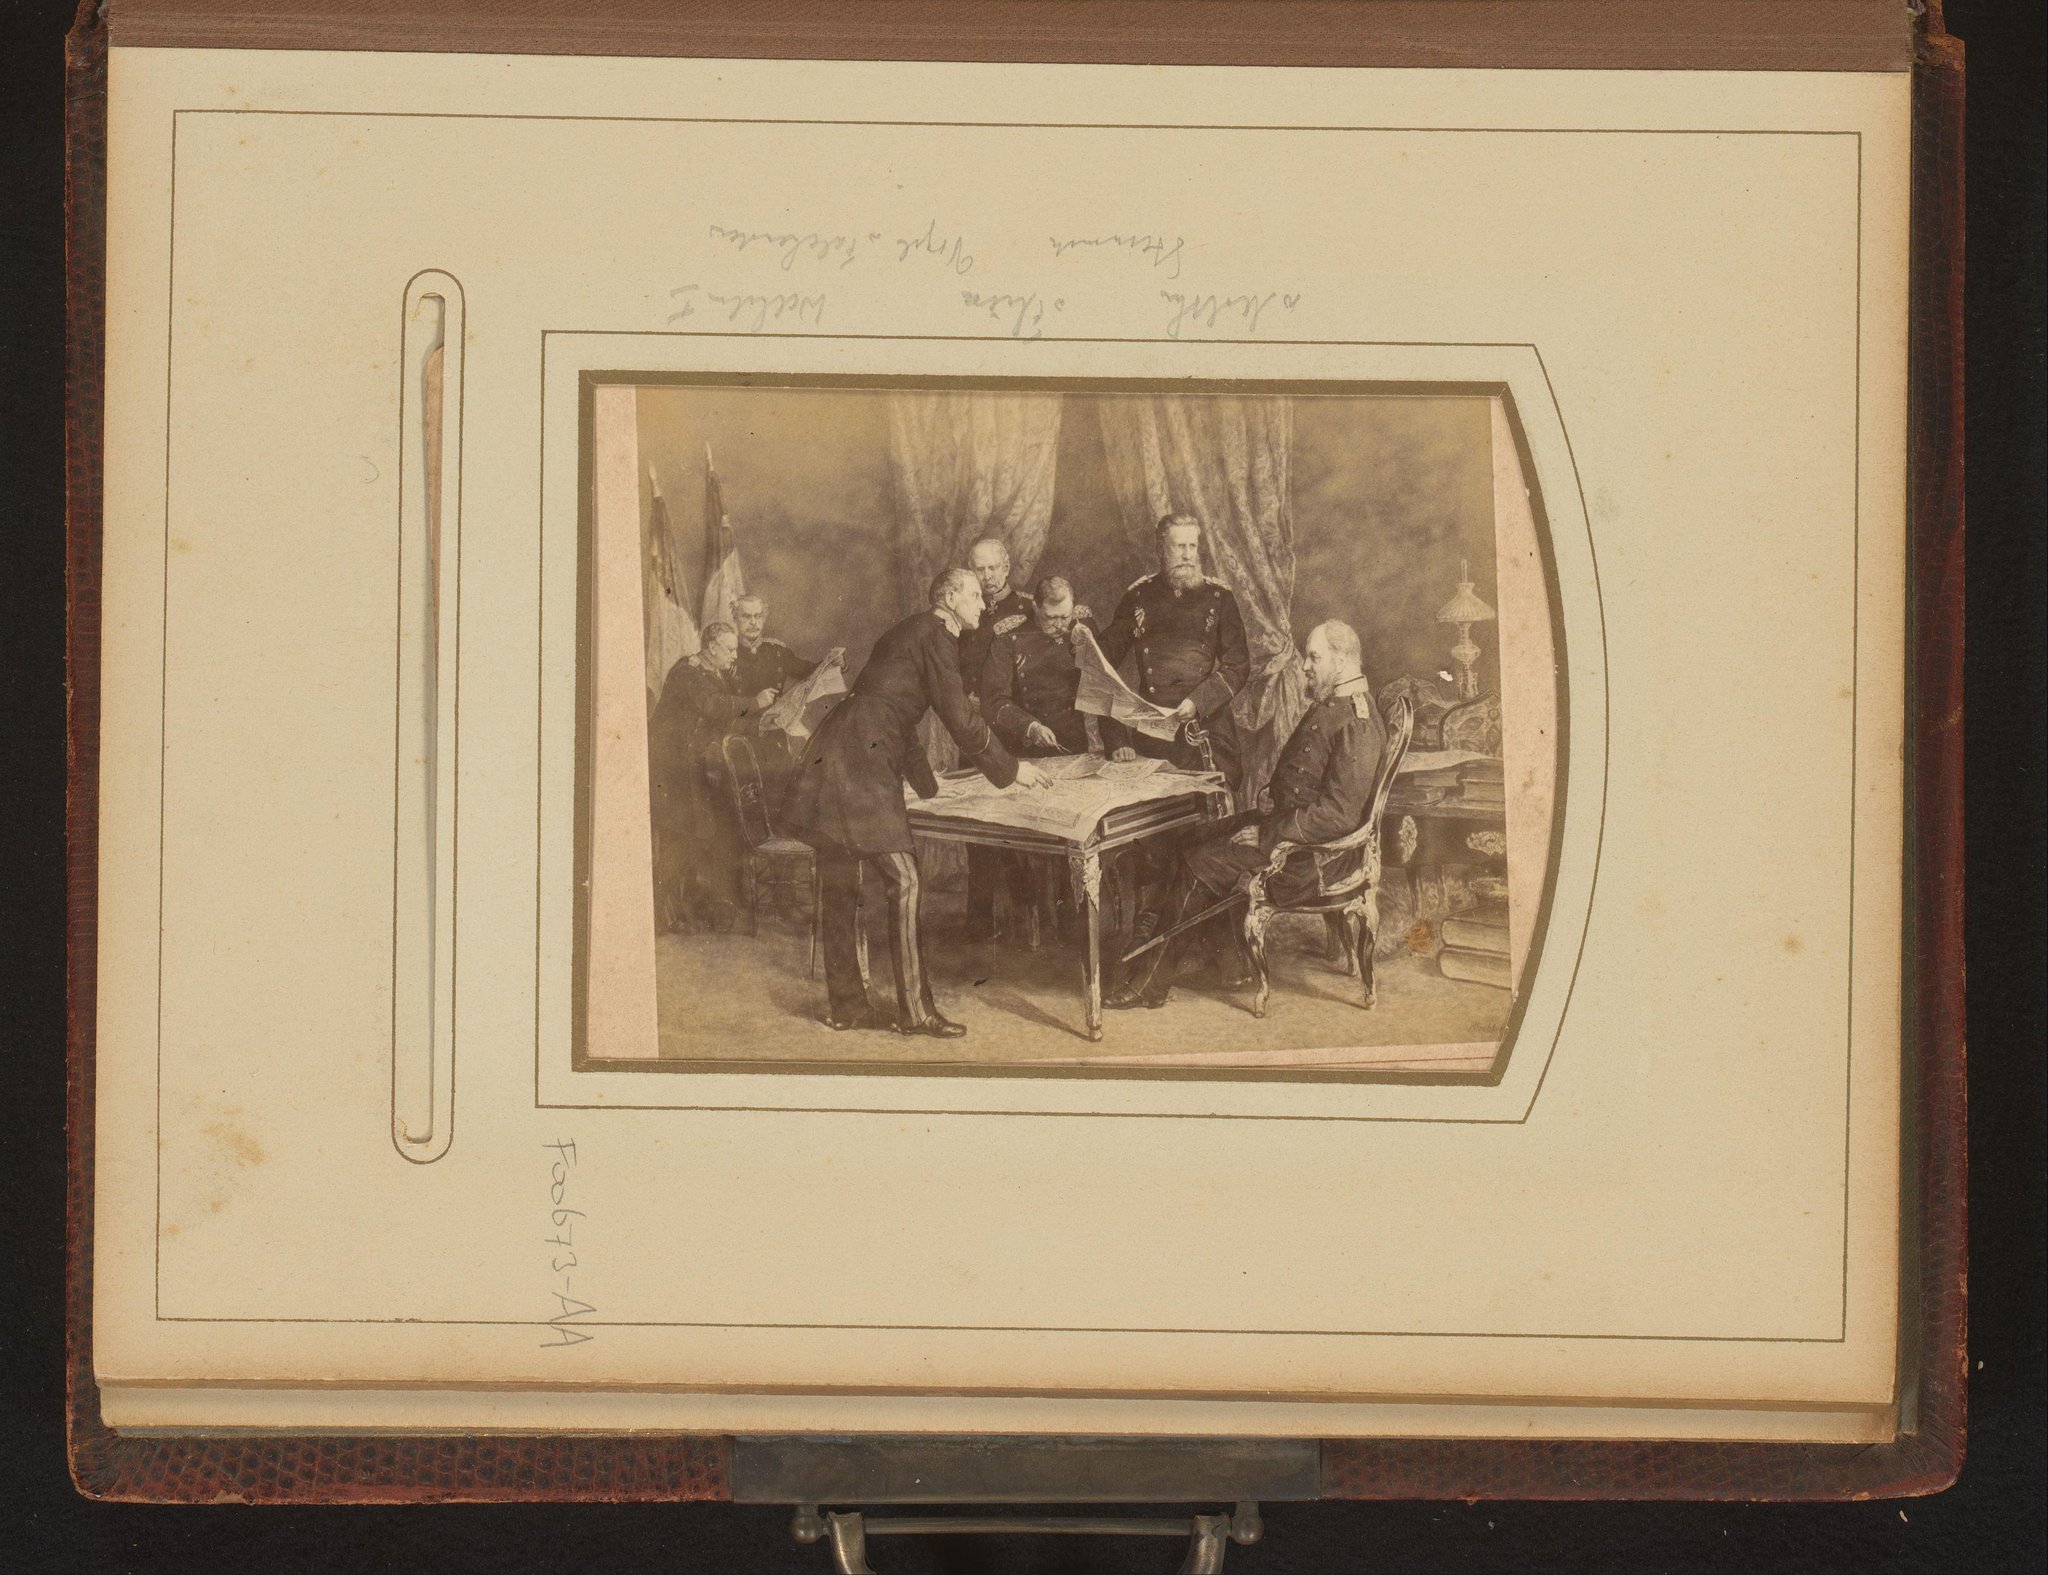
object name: album leaf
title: Fotoreproductie van een schilderij van een militair overleg te Versailles naar Georg Bleibtreu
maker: georg bleibtreu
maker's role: artist, painter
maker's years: 1828-1892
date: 1870-1880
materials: cardboard, photographic support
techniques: albumen print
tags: berlin, council of war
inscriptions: inscription: ‘Photographische Gesellschaft/ Berlin/ Dönhofs-Platz’, annotation: ‘Moltke [...] Wilhelm I [...]’, collector's mark: ‘Kunsthandel van S. Herz, Heerengracht 80, Amsterdam (...)’, inscription: ‘Kriegsrath zu Versailles/ 755.’